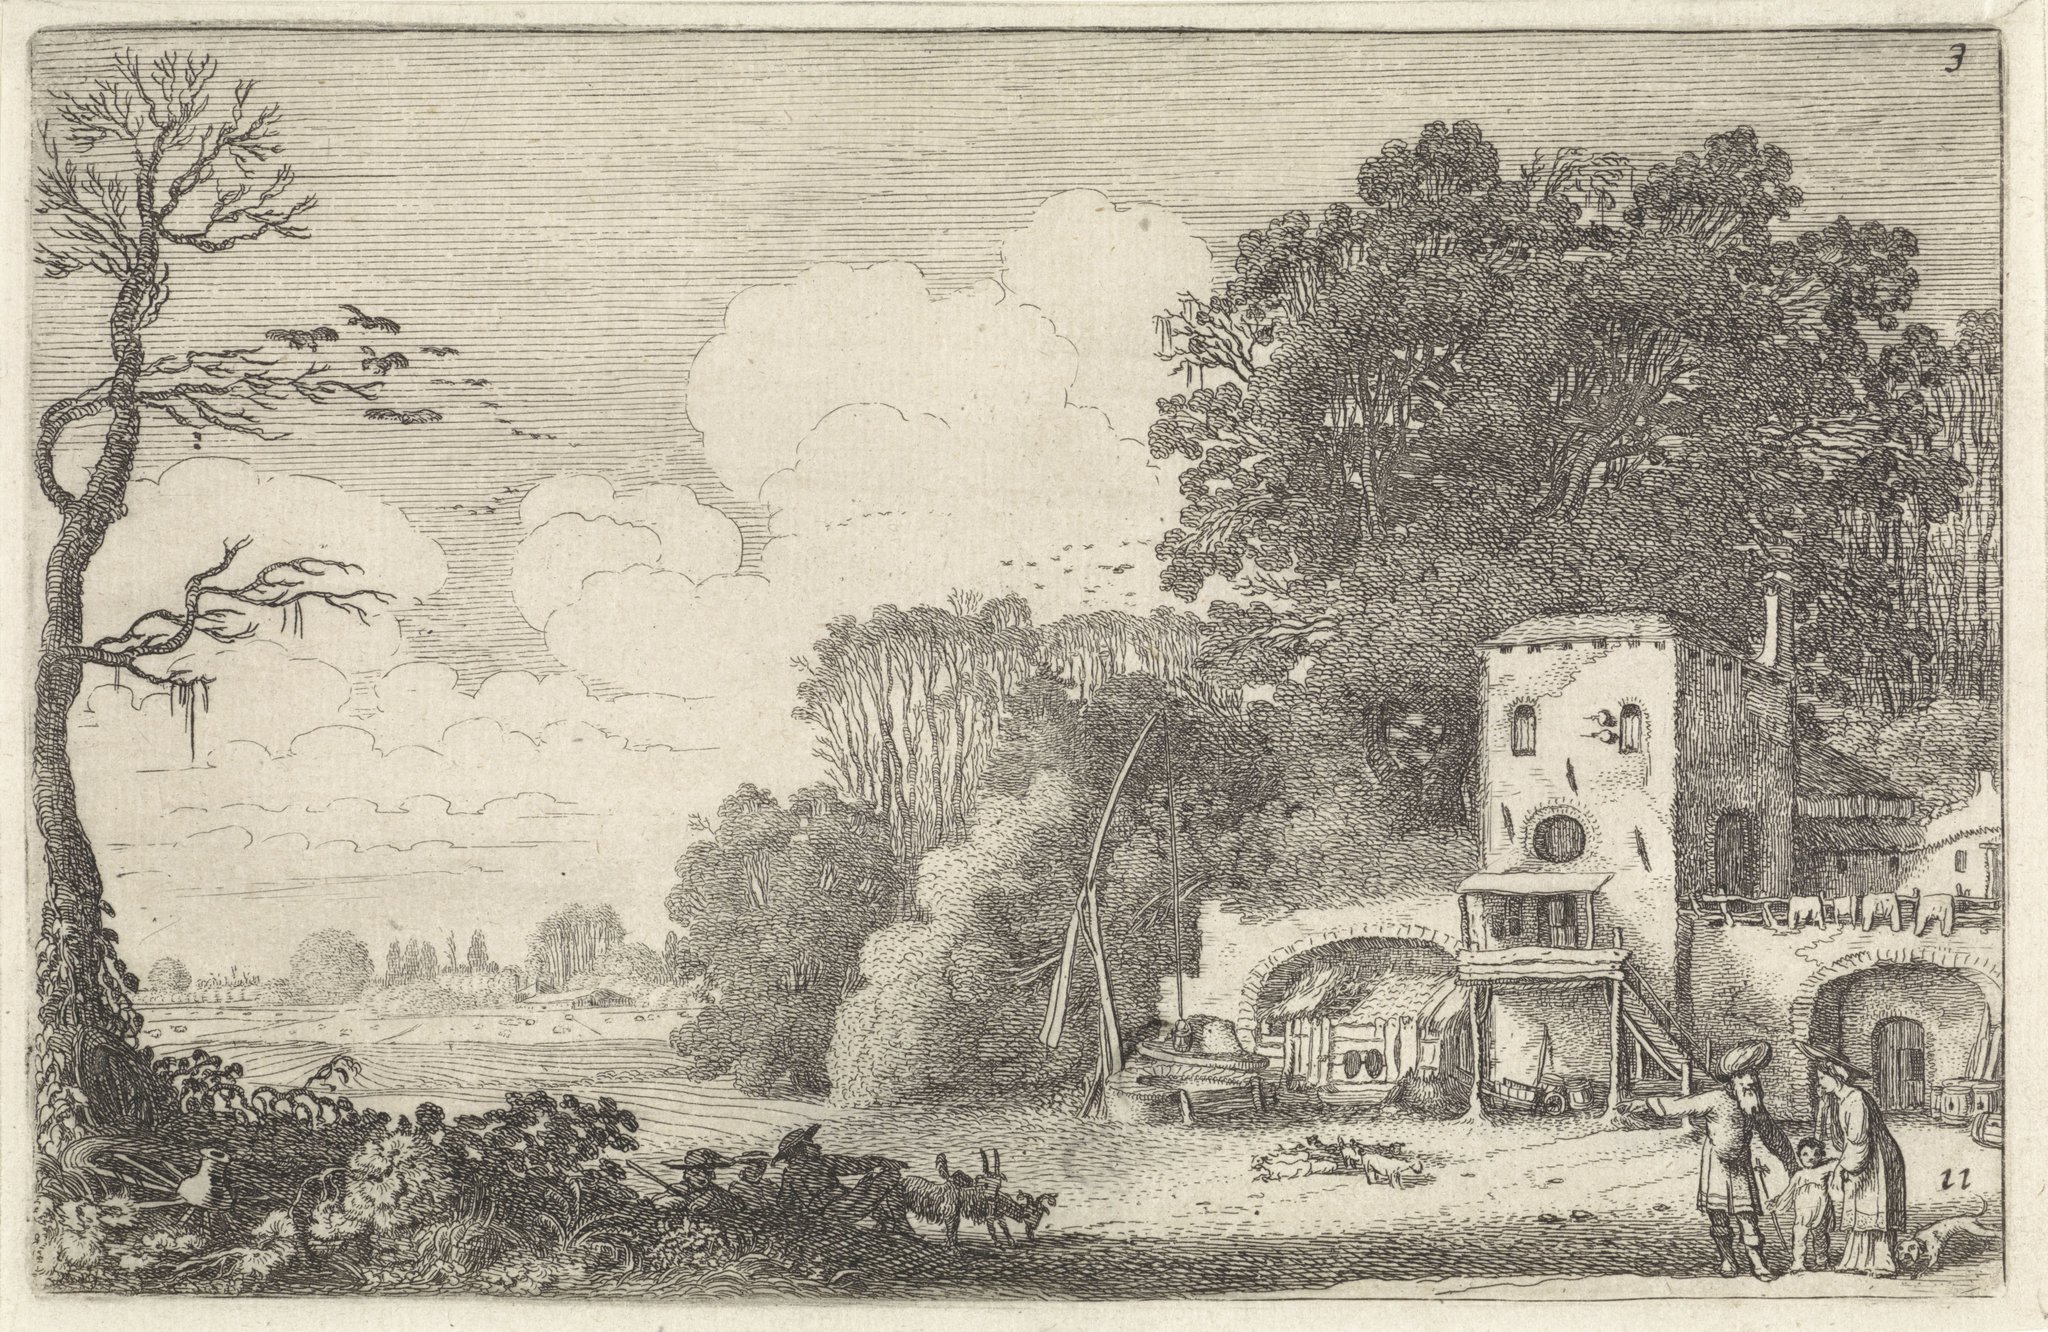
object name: print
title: Landschappen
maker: jan van de velde (ii)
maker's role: draughtsman, painter, print maker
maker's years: 1593-1641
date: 1616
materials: paper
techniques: etching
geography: northern netherlands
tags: herding, herdsman, herdswoman, shepherd, shepherdess, cowherd, etc., the banishment of hagar and ishmael (genesis 21:9-21), farm or solitary house in landscape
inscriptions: collector's mark: Lugt 964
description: Een landschap met een huis waarvoor een man, een vrouw en een kind (Abraham, Hagar en Ismael) staan (Gen. 21:9-21). De man heeft de rechterhand uitgestoken in een wijzend gebaar. In het midden op de voorgrond drie rustende herders. Elfde prent van deel drie van een serie van in totaal zestig prenten met landschappen, verdeeld over vijf delen van elk twaalf prenten.